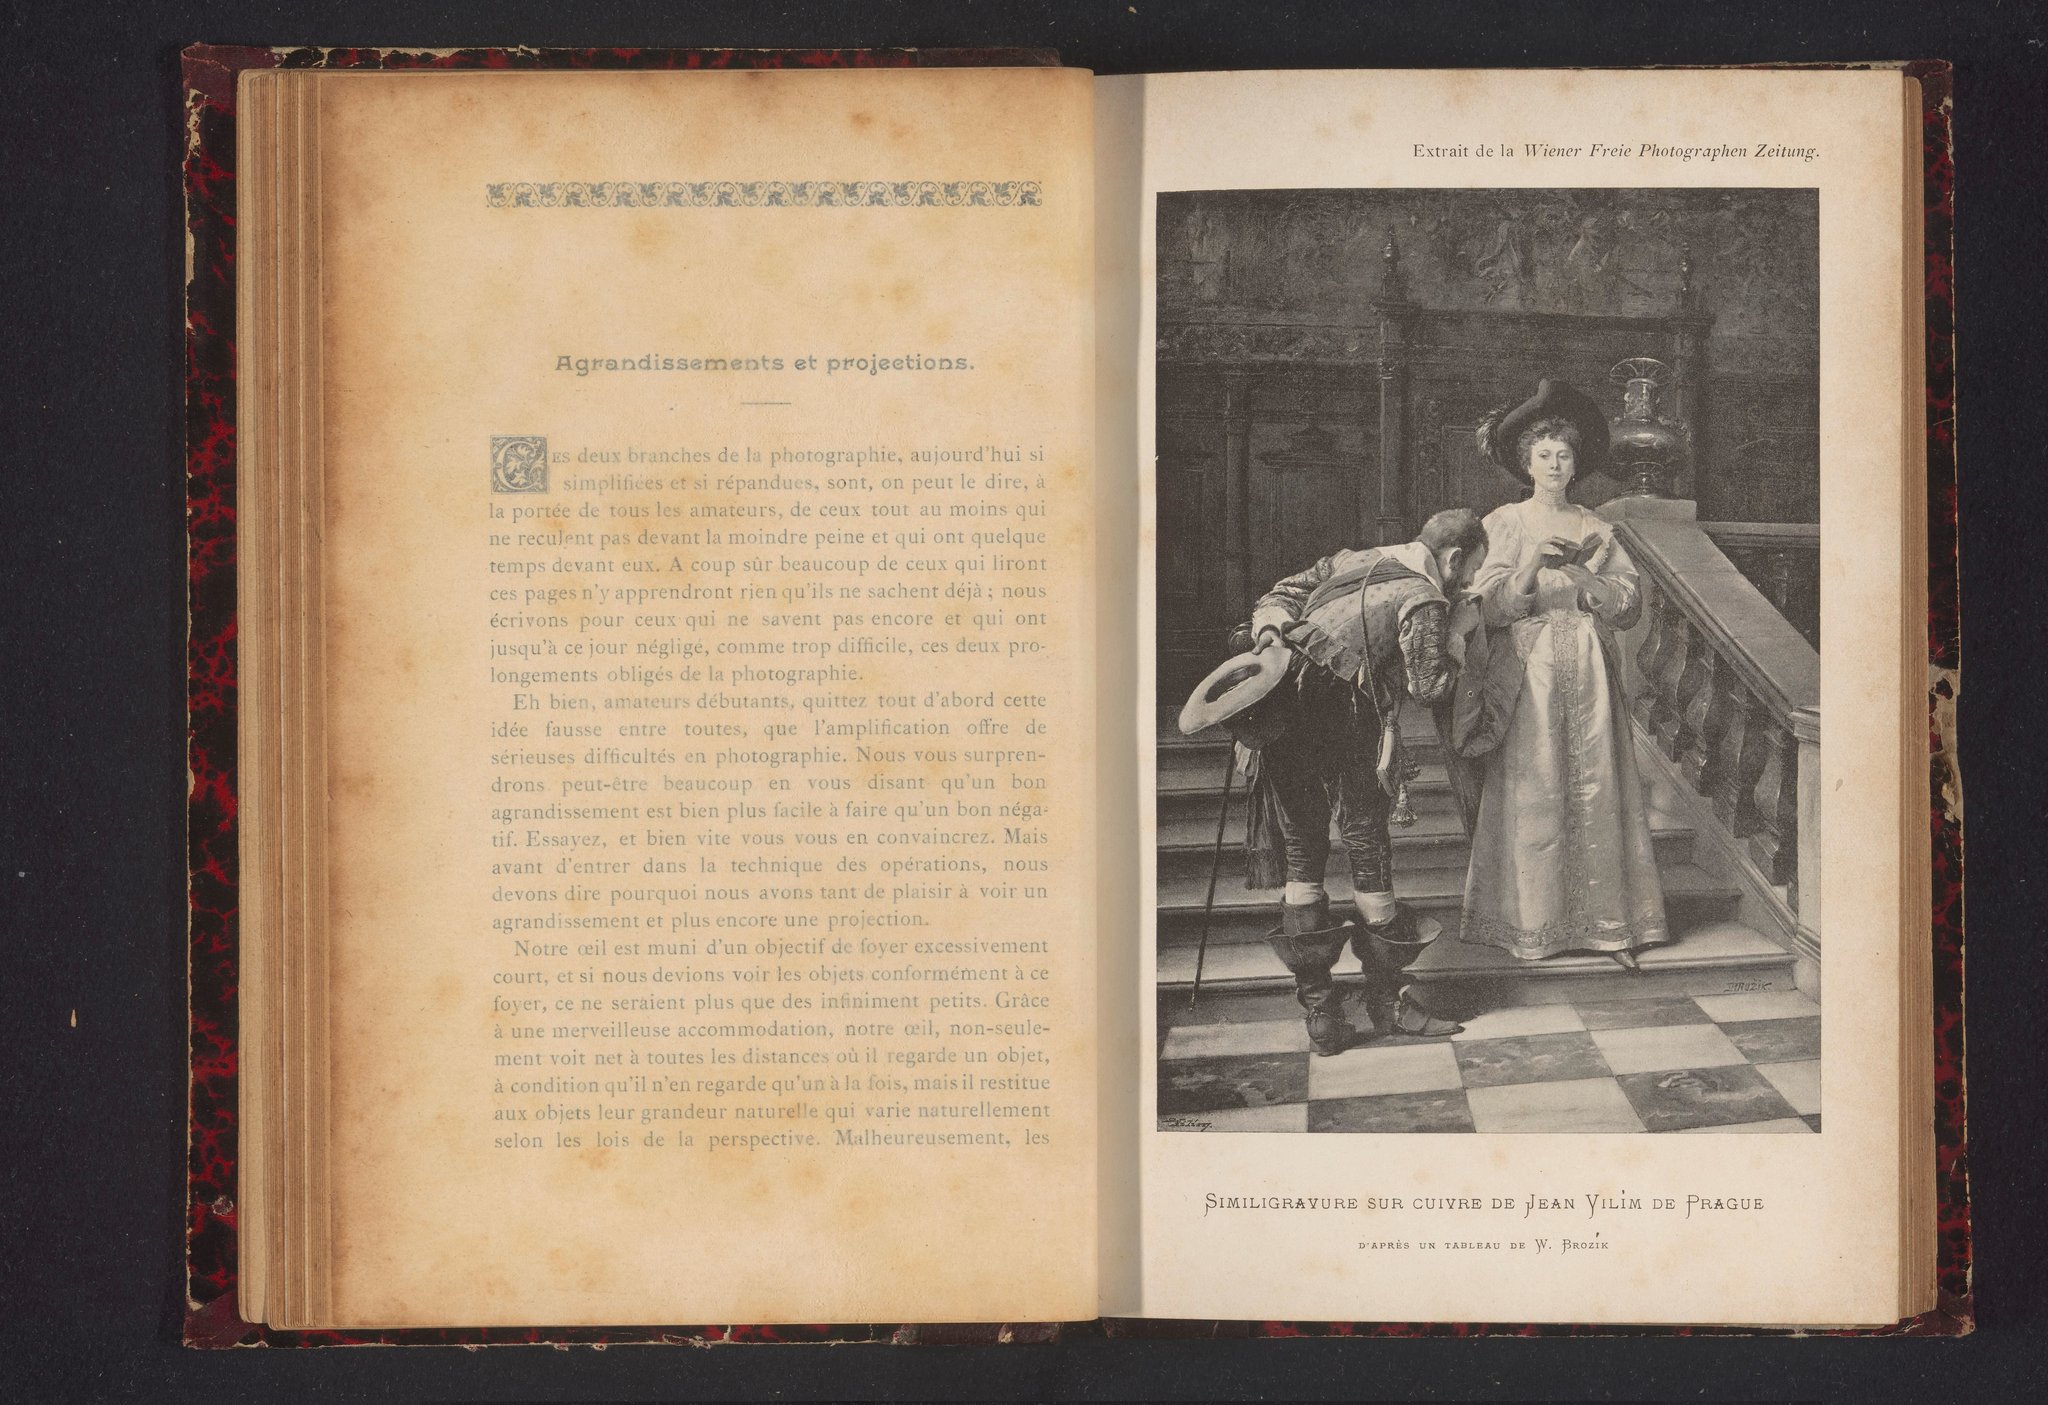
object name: reproduction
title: Reproductie van een schilderij door Václav Brožík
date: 1894-1899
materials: paper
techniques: autotype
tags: adult woman, adult man, staircase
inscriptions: inscription: ‘Extrait de la Wiener Freie Photographen Zeitung.’